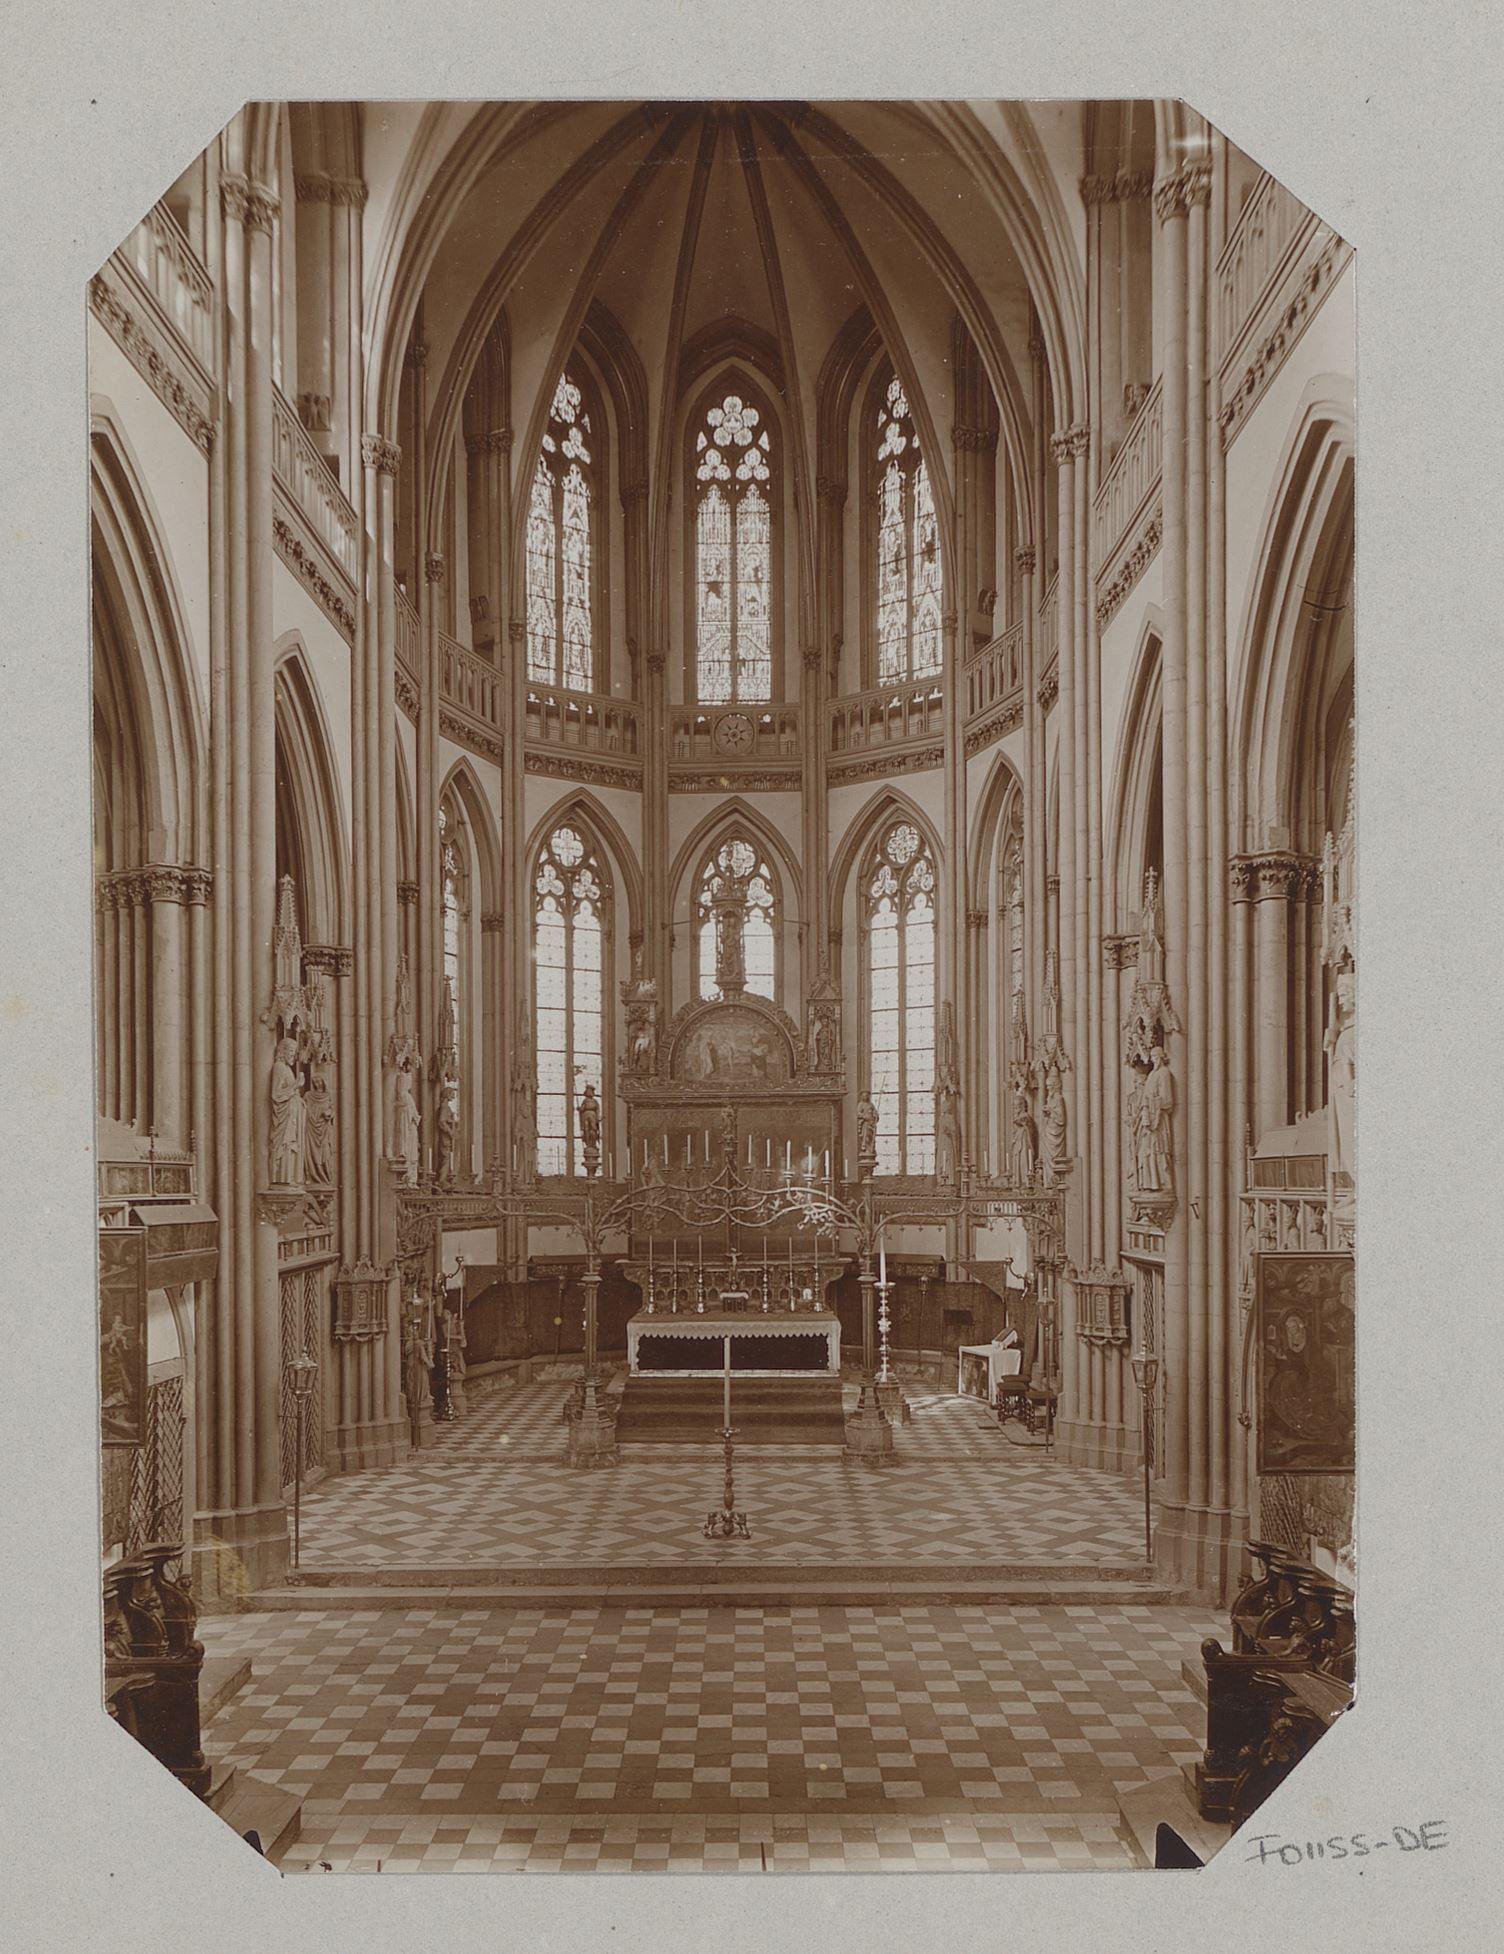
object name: photograph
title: Interieur van het koor van de Dom van Xanten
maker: Anonymous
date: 1890-1902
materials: photographic support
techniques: collodion silver print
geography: xanten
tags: parts of church interior: choir